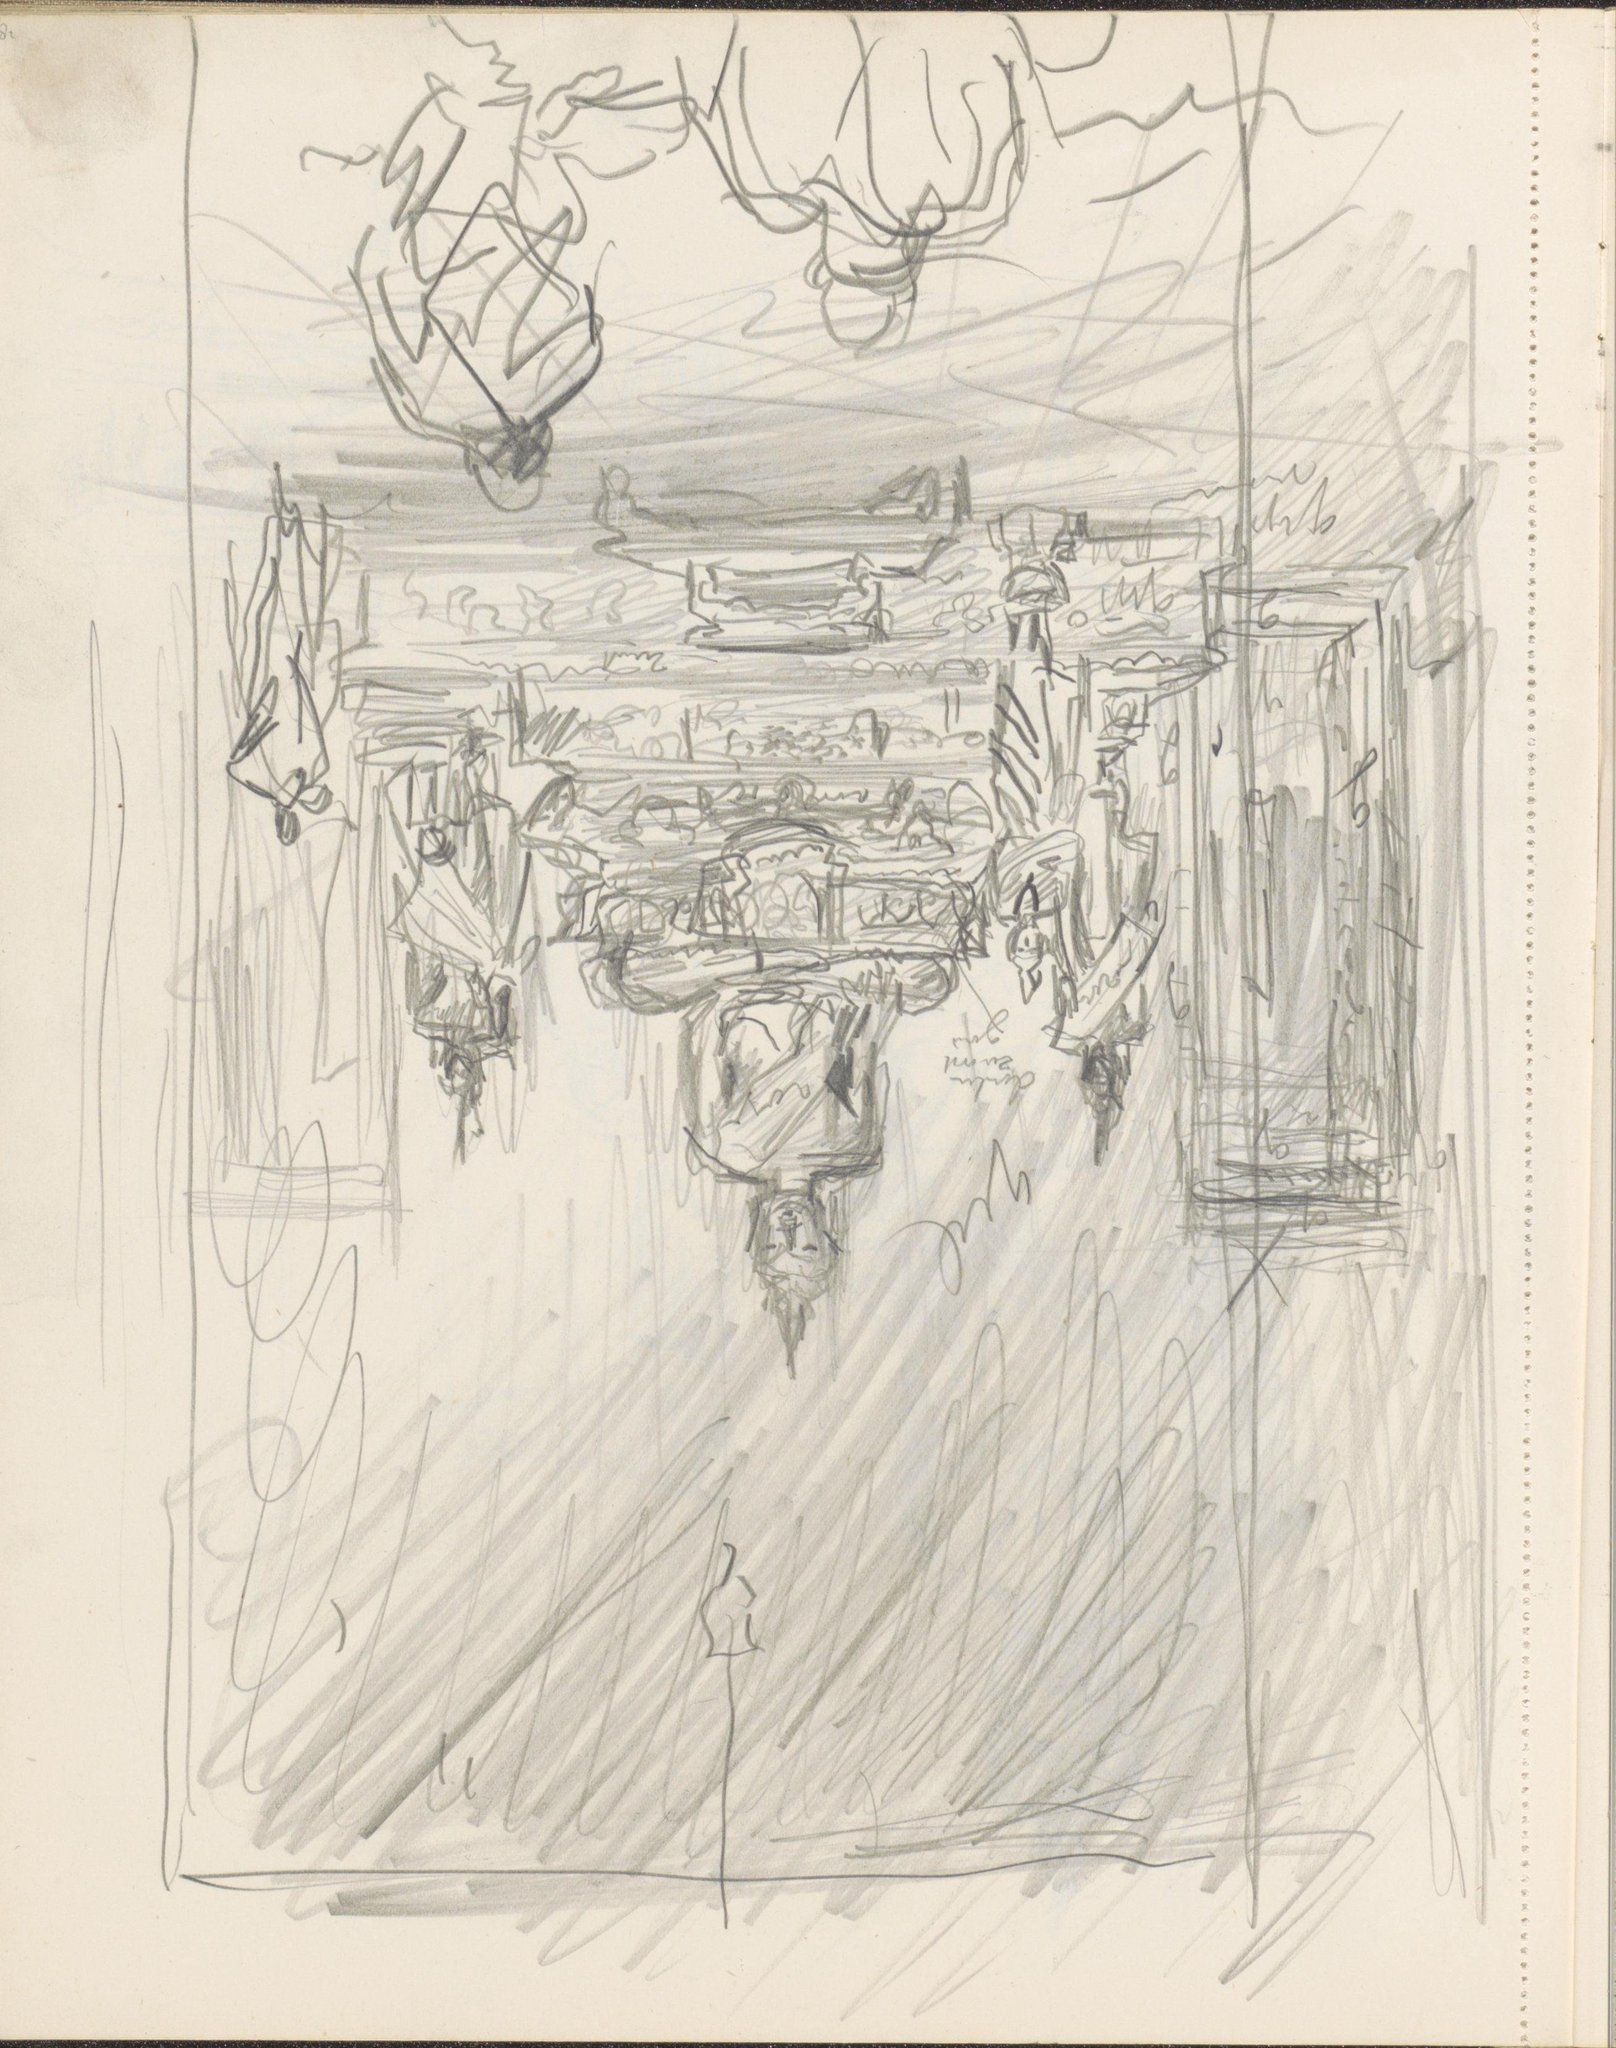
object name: sketchbook leaf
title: Figuren bij een altaar met een Boeddhabeeld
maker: marius bauer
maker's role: draughtsman, print maker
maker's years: 1867-1932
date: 1931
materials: paper, pencil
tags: altar ~ hinduism, buddhism, jainism, statues, paintings, etc. ~ objects of worship (hinduism, buddhism, jainism)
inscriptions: kleurnotitie, handgeschreven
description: Pagina 82 uit een schetsboek met 48 bladen.